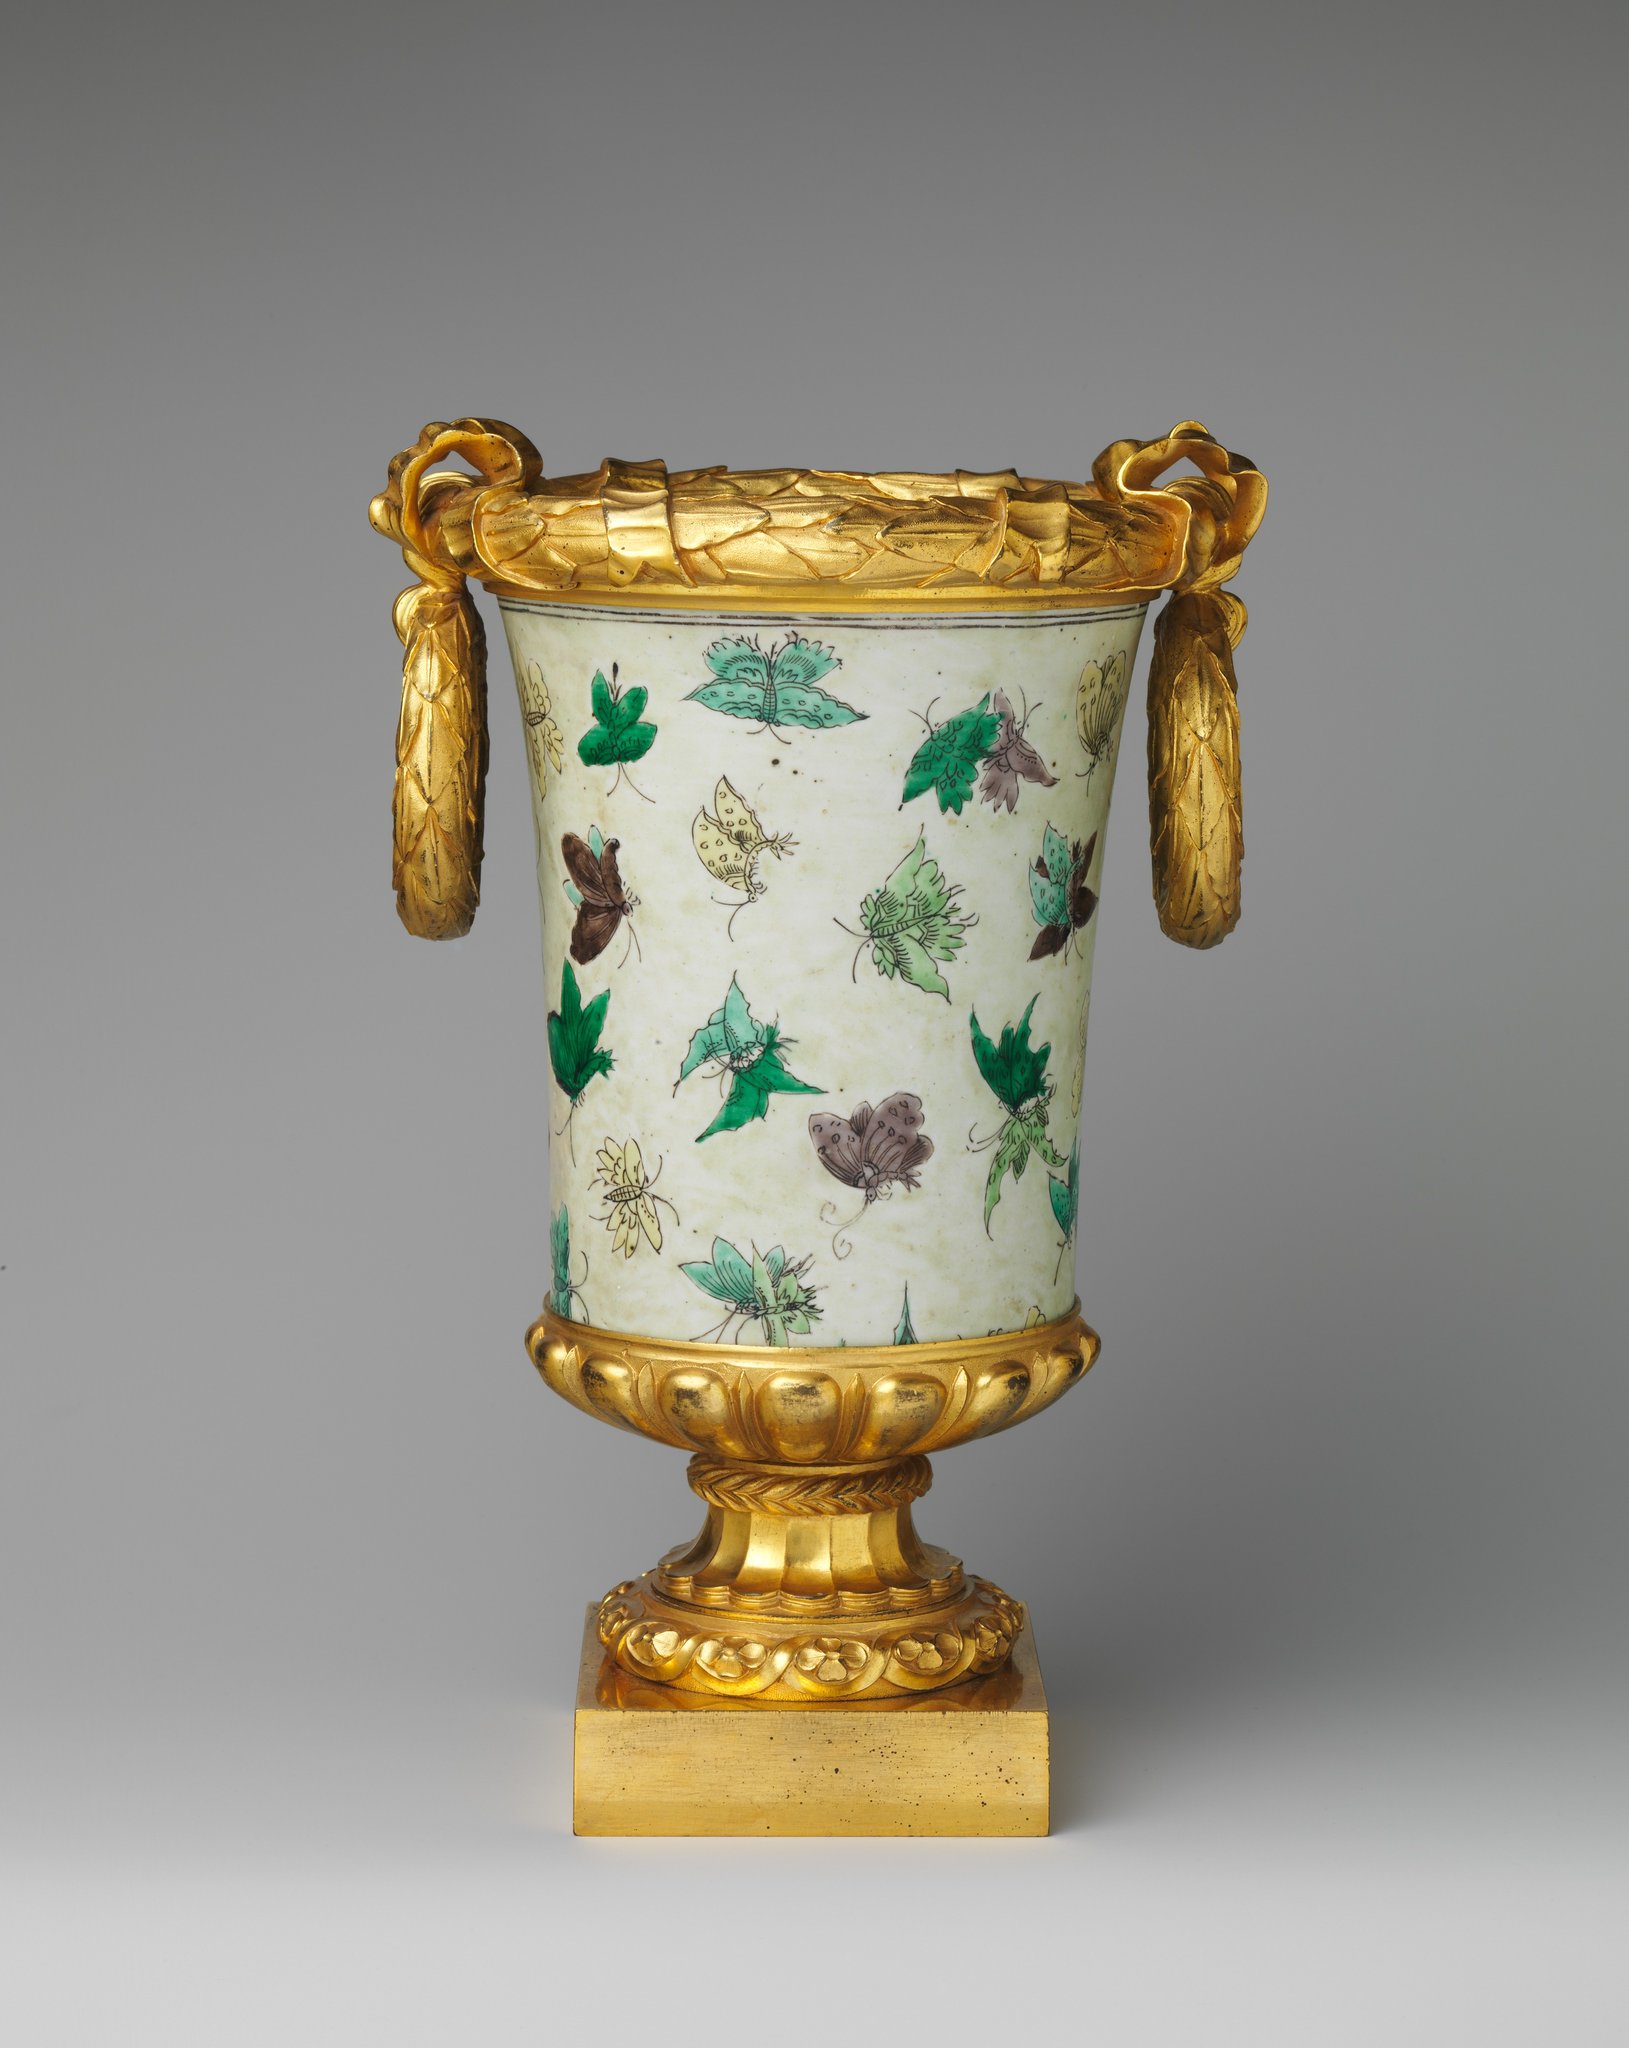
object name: vase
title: Pair of mounted vases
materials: gilt bronze, porcelain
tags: butterflies